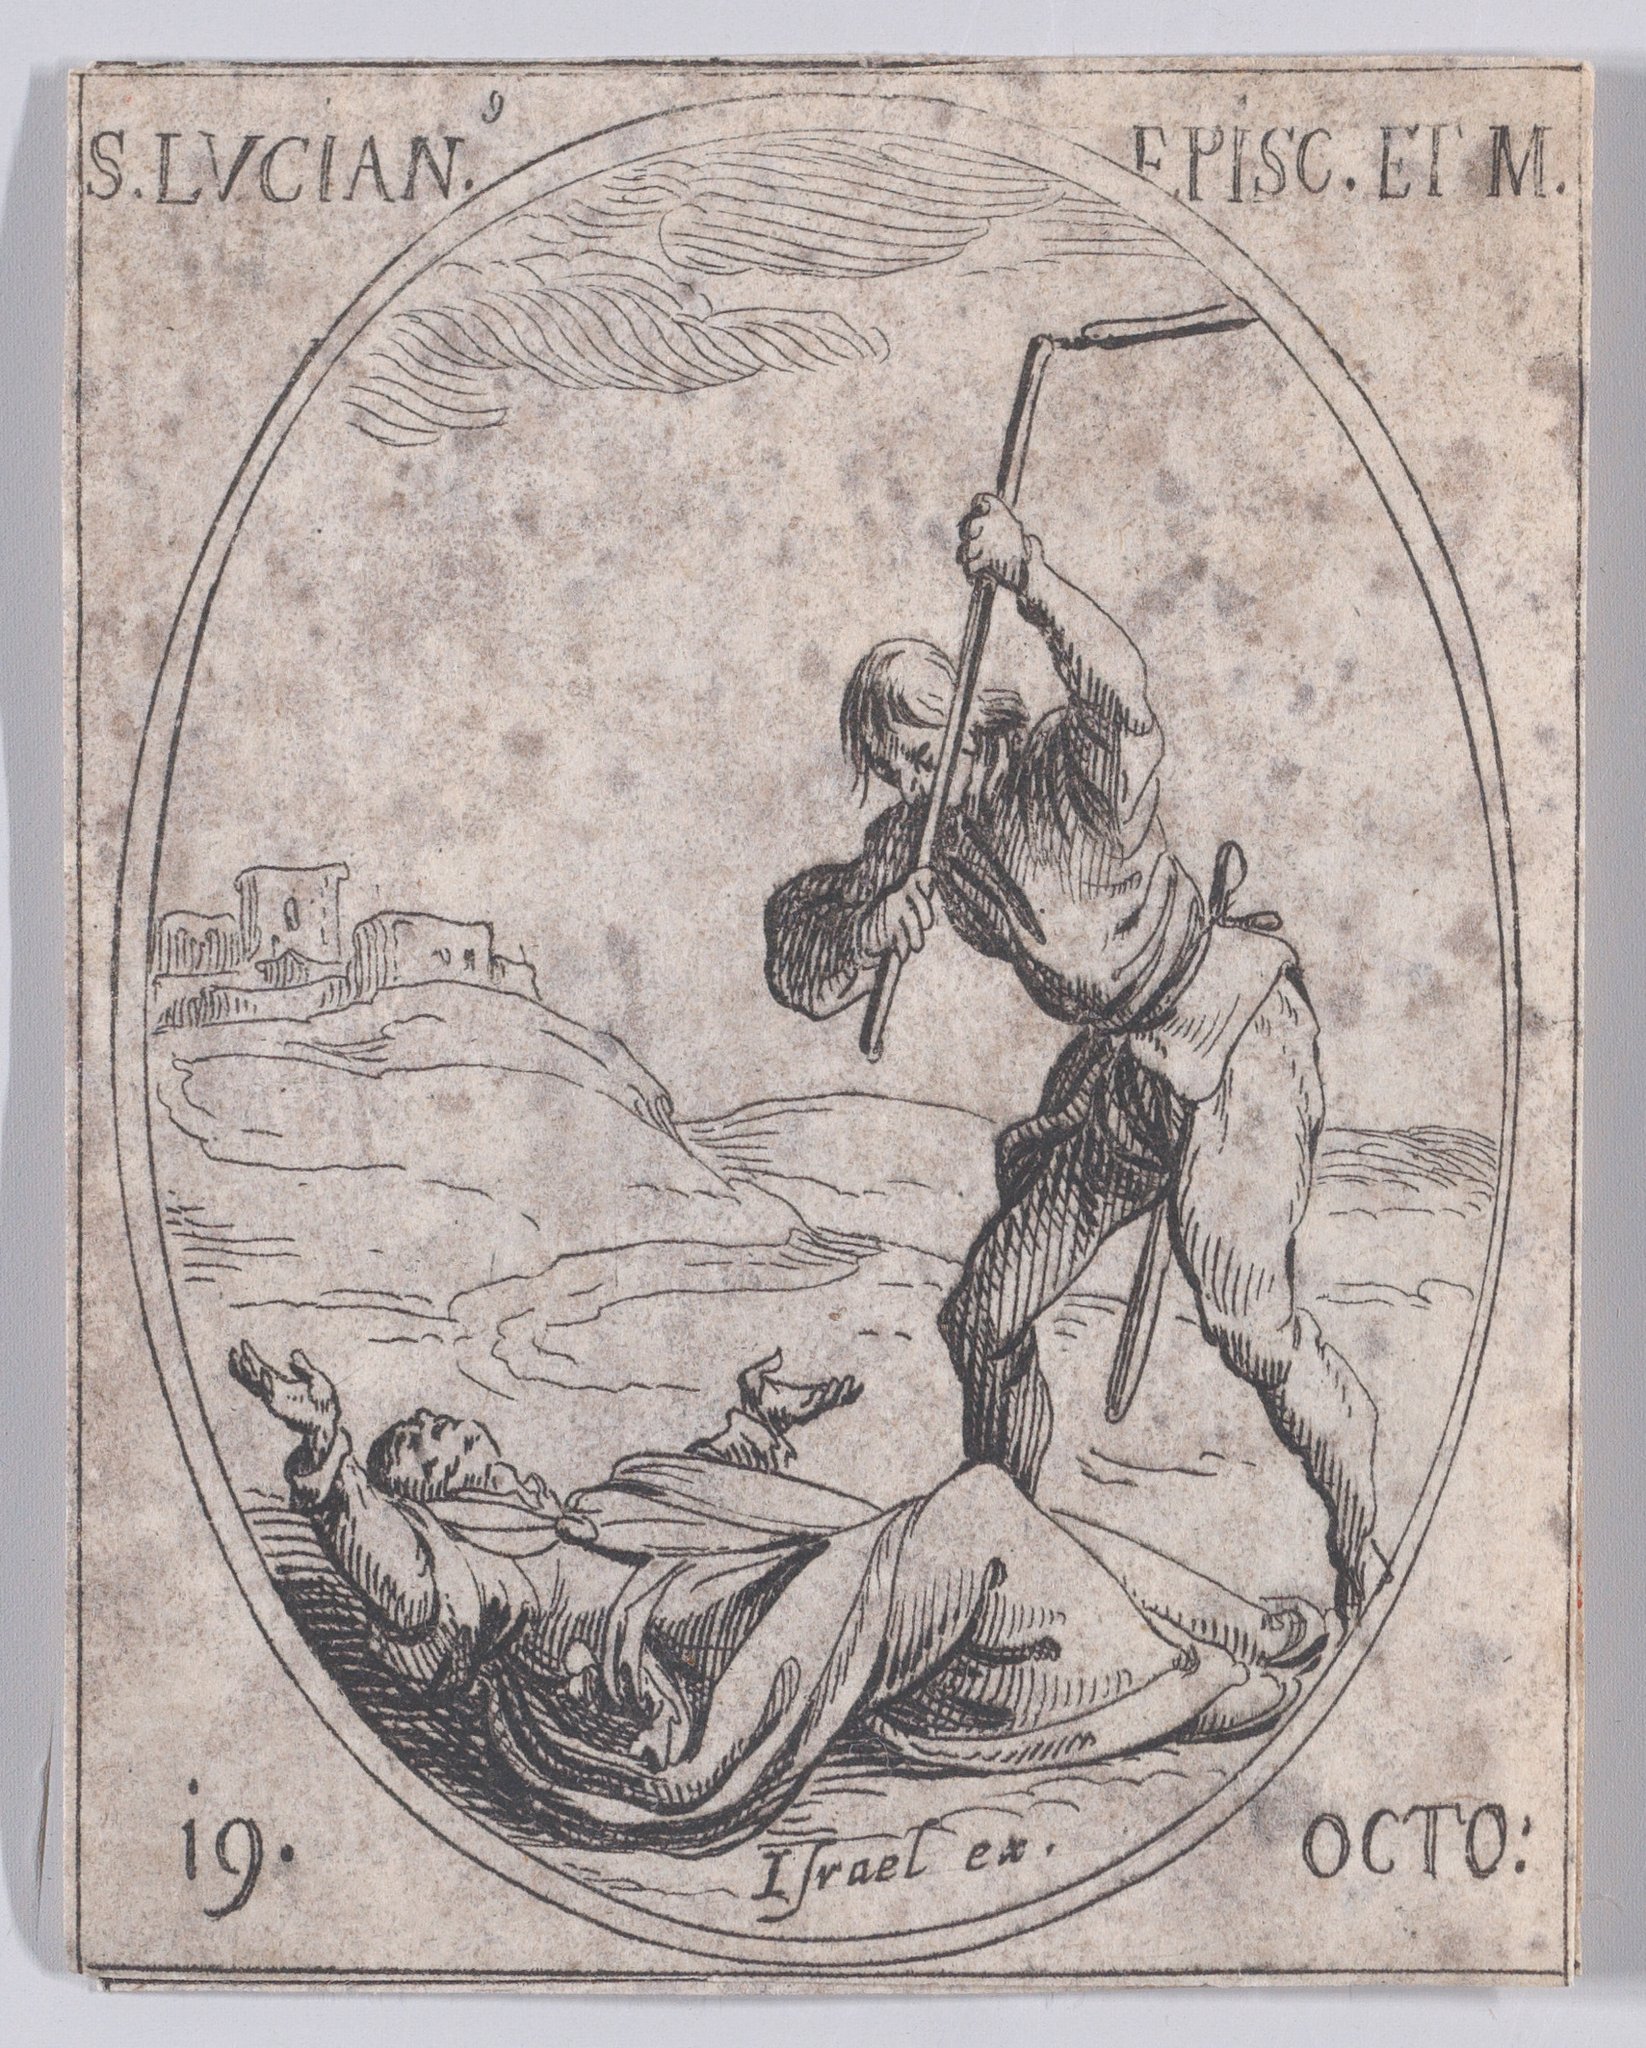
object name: print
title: S. Lucien, évêque (St. Lucian, Bishop), October 19th, from "Les Images De Tous Les Saincts et Saintes de L'Année" (Images of All of the Saints and Religious Events of the Year)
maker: jacques callot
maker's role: artist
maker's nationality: french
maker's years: 1592-1635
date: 1636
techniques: etching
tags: men,saints